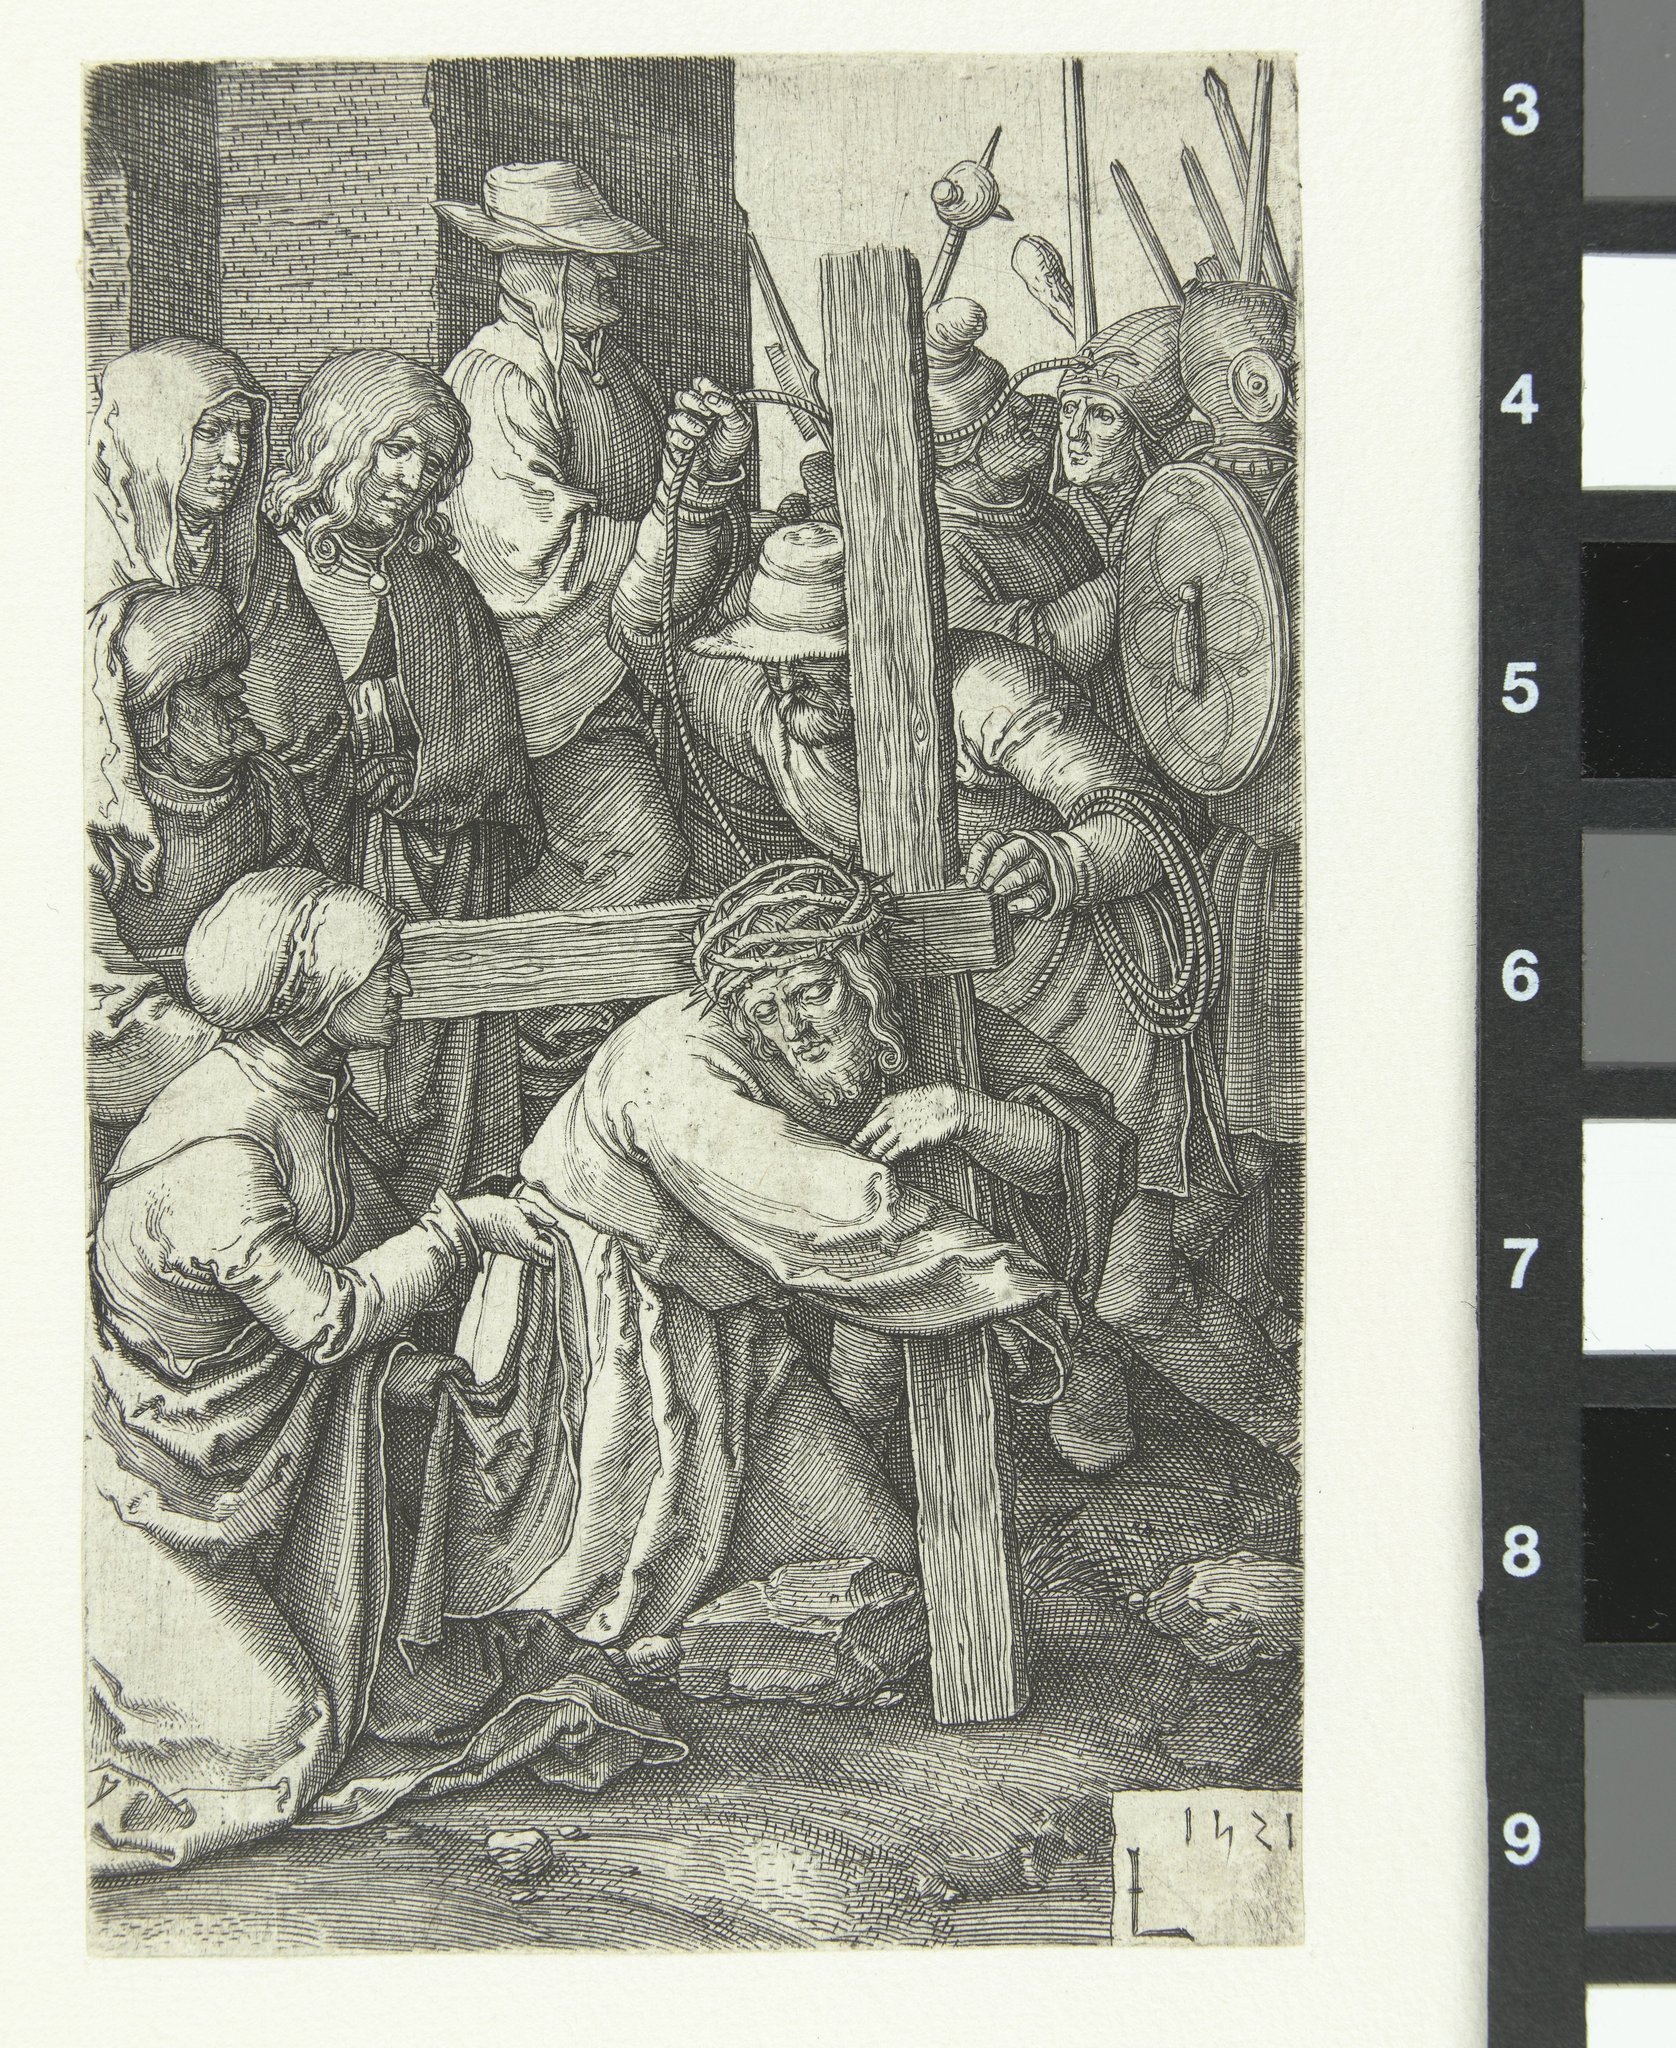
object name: print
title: De kruisdraging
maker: lucas van leyden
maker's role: draughtsman, painter, print maker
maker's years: 1494-1533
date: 1521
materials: paper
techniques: engraving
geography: low countries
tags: christ meets veronica, who has a cloth to wipe christ's face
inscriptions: date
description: Christus het kruis dragend, wordt geholpen door Simon. Veronica, geknield naast Christus, houdt de zweetdoek vast.